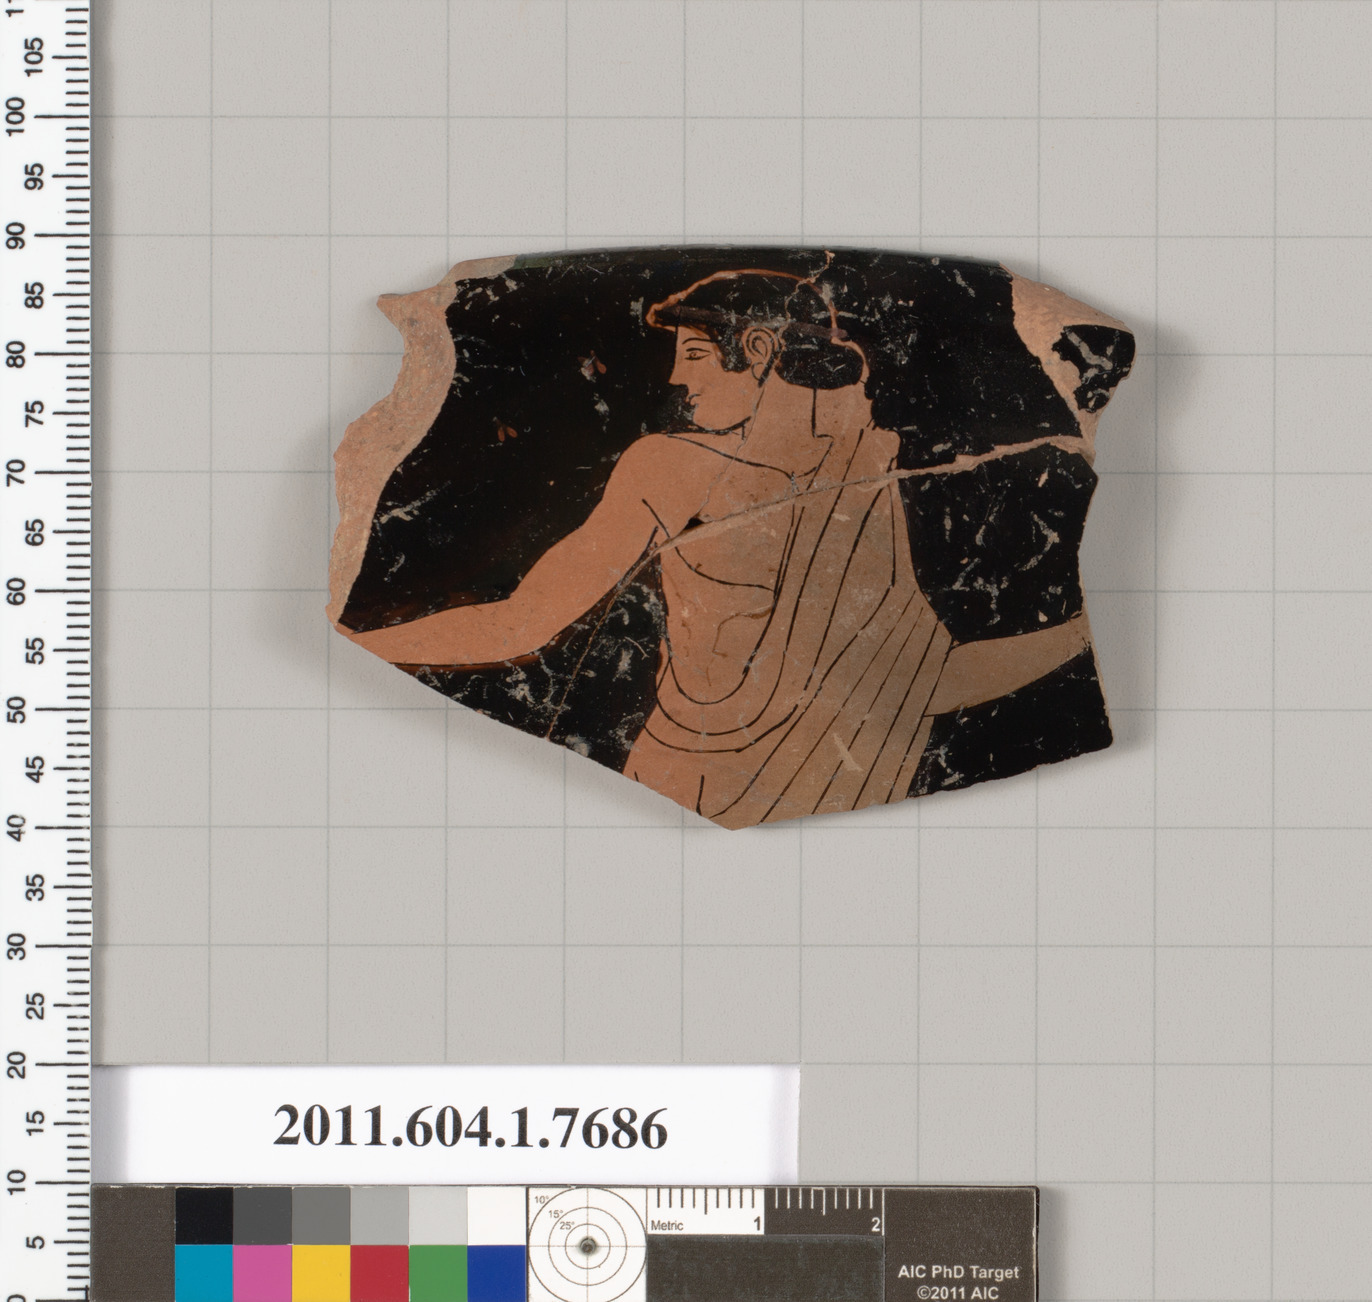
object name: kylix fragment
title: Terracotta rim fragment of a kylix (drinking cup)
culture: greek, attic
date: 475-451 BCE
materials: terracotta